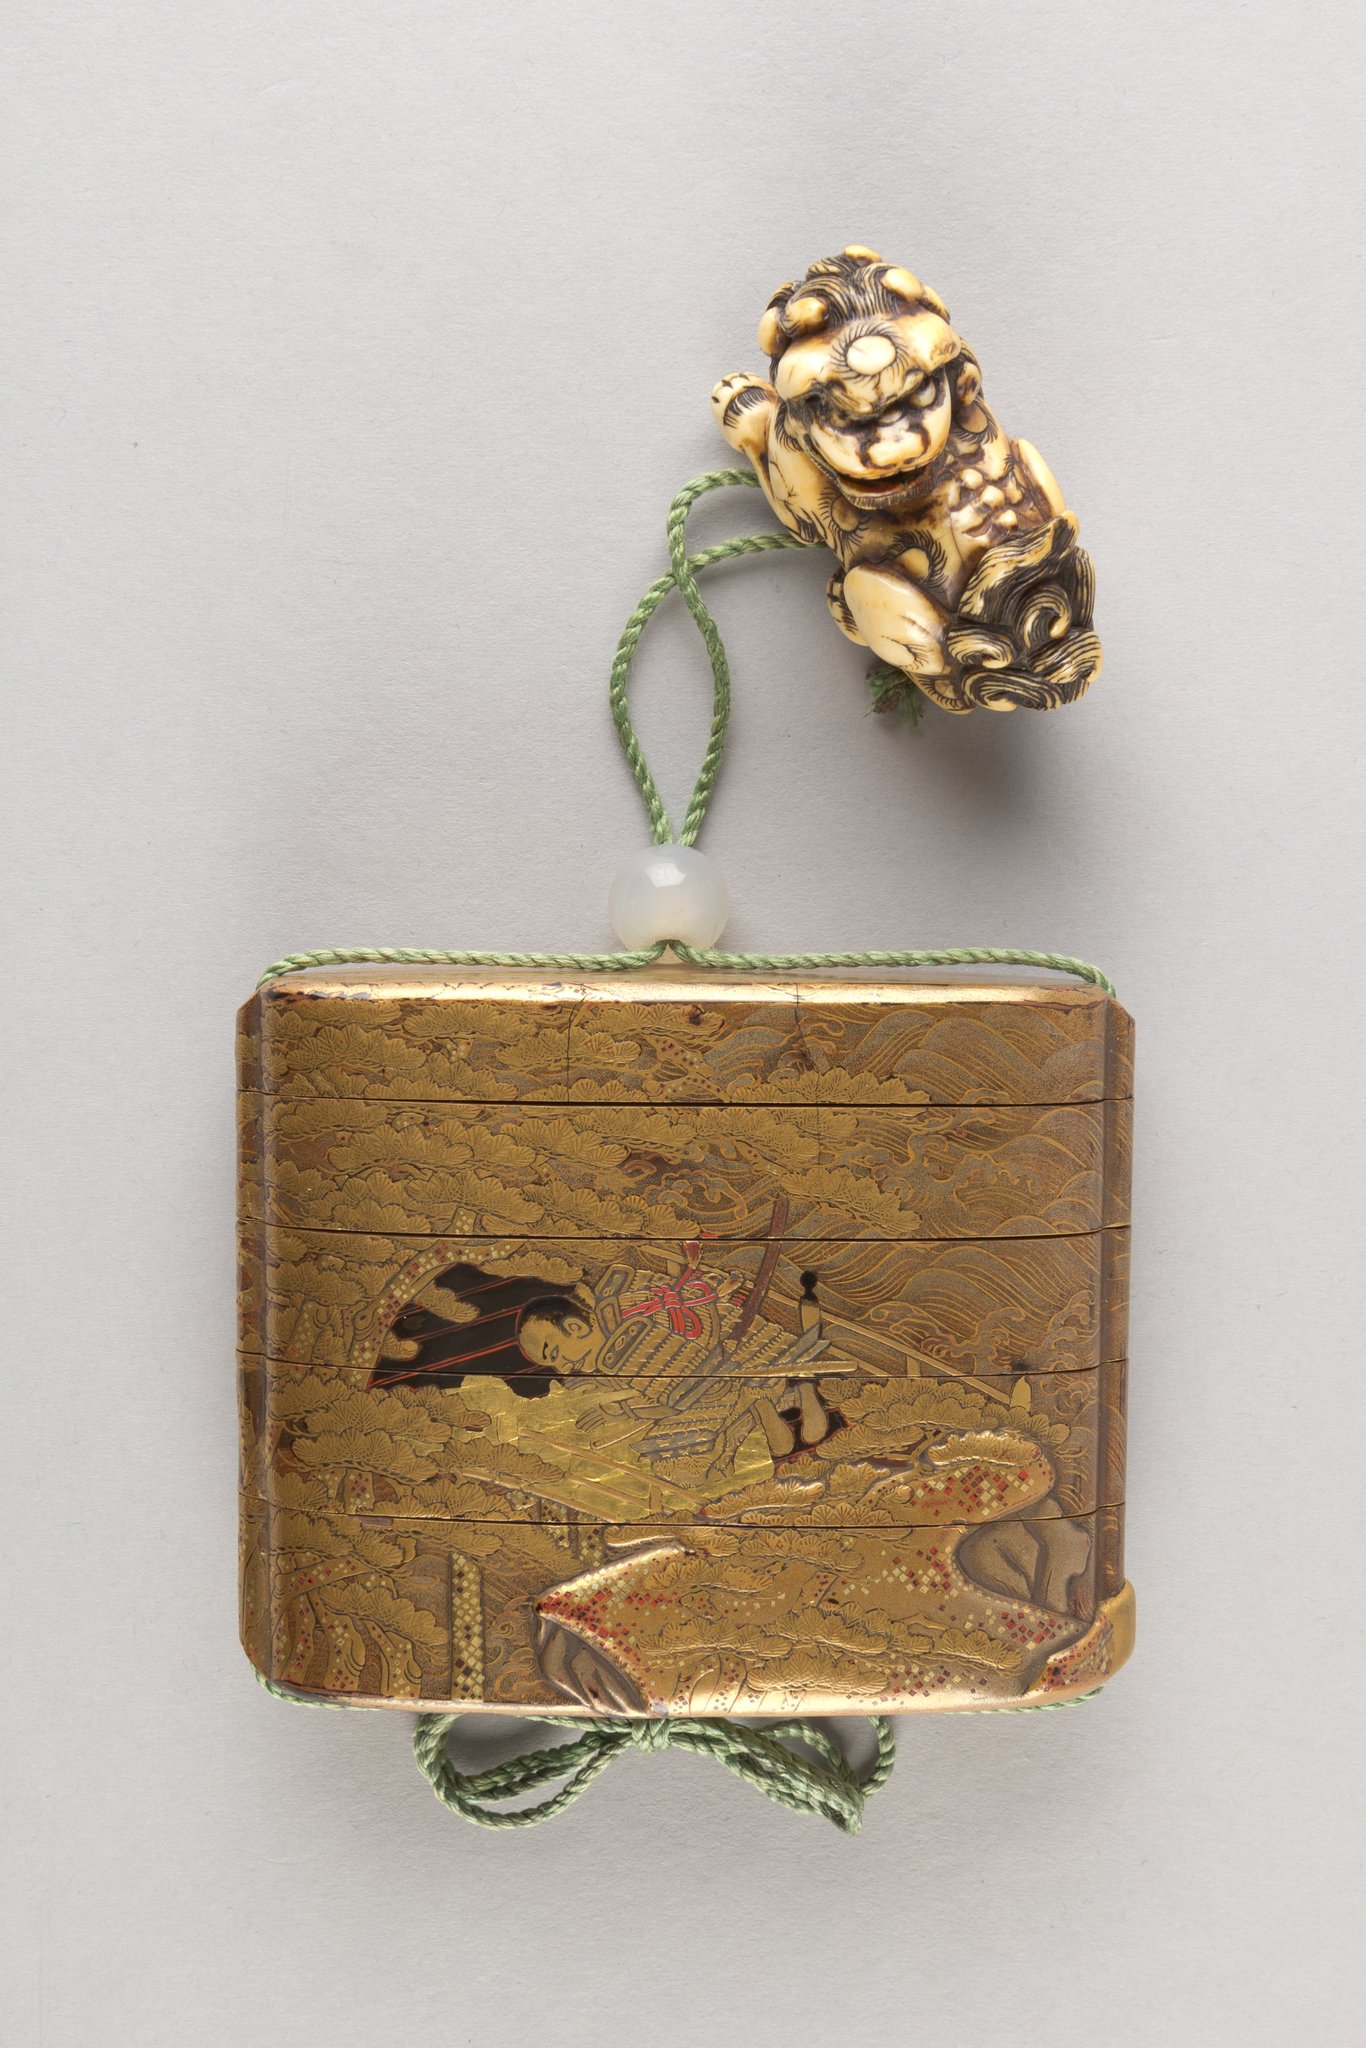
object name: inrō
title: Case (Inrō) with Design of Samurai Kneeling on Bridge among Pines and Waves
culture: japanese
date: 1601-1800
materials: gold, gold foil, lacquer, silver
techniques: fundame, hiramakie, maki-e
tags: bridges,samurai,men,waves